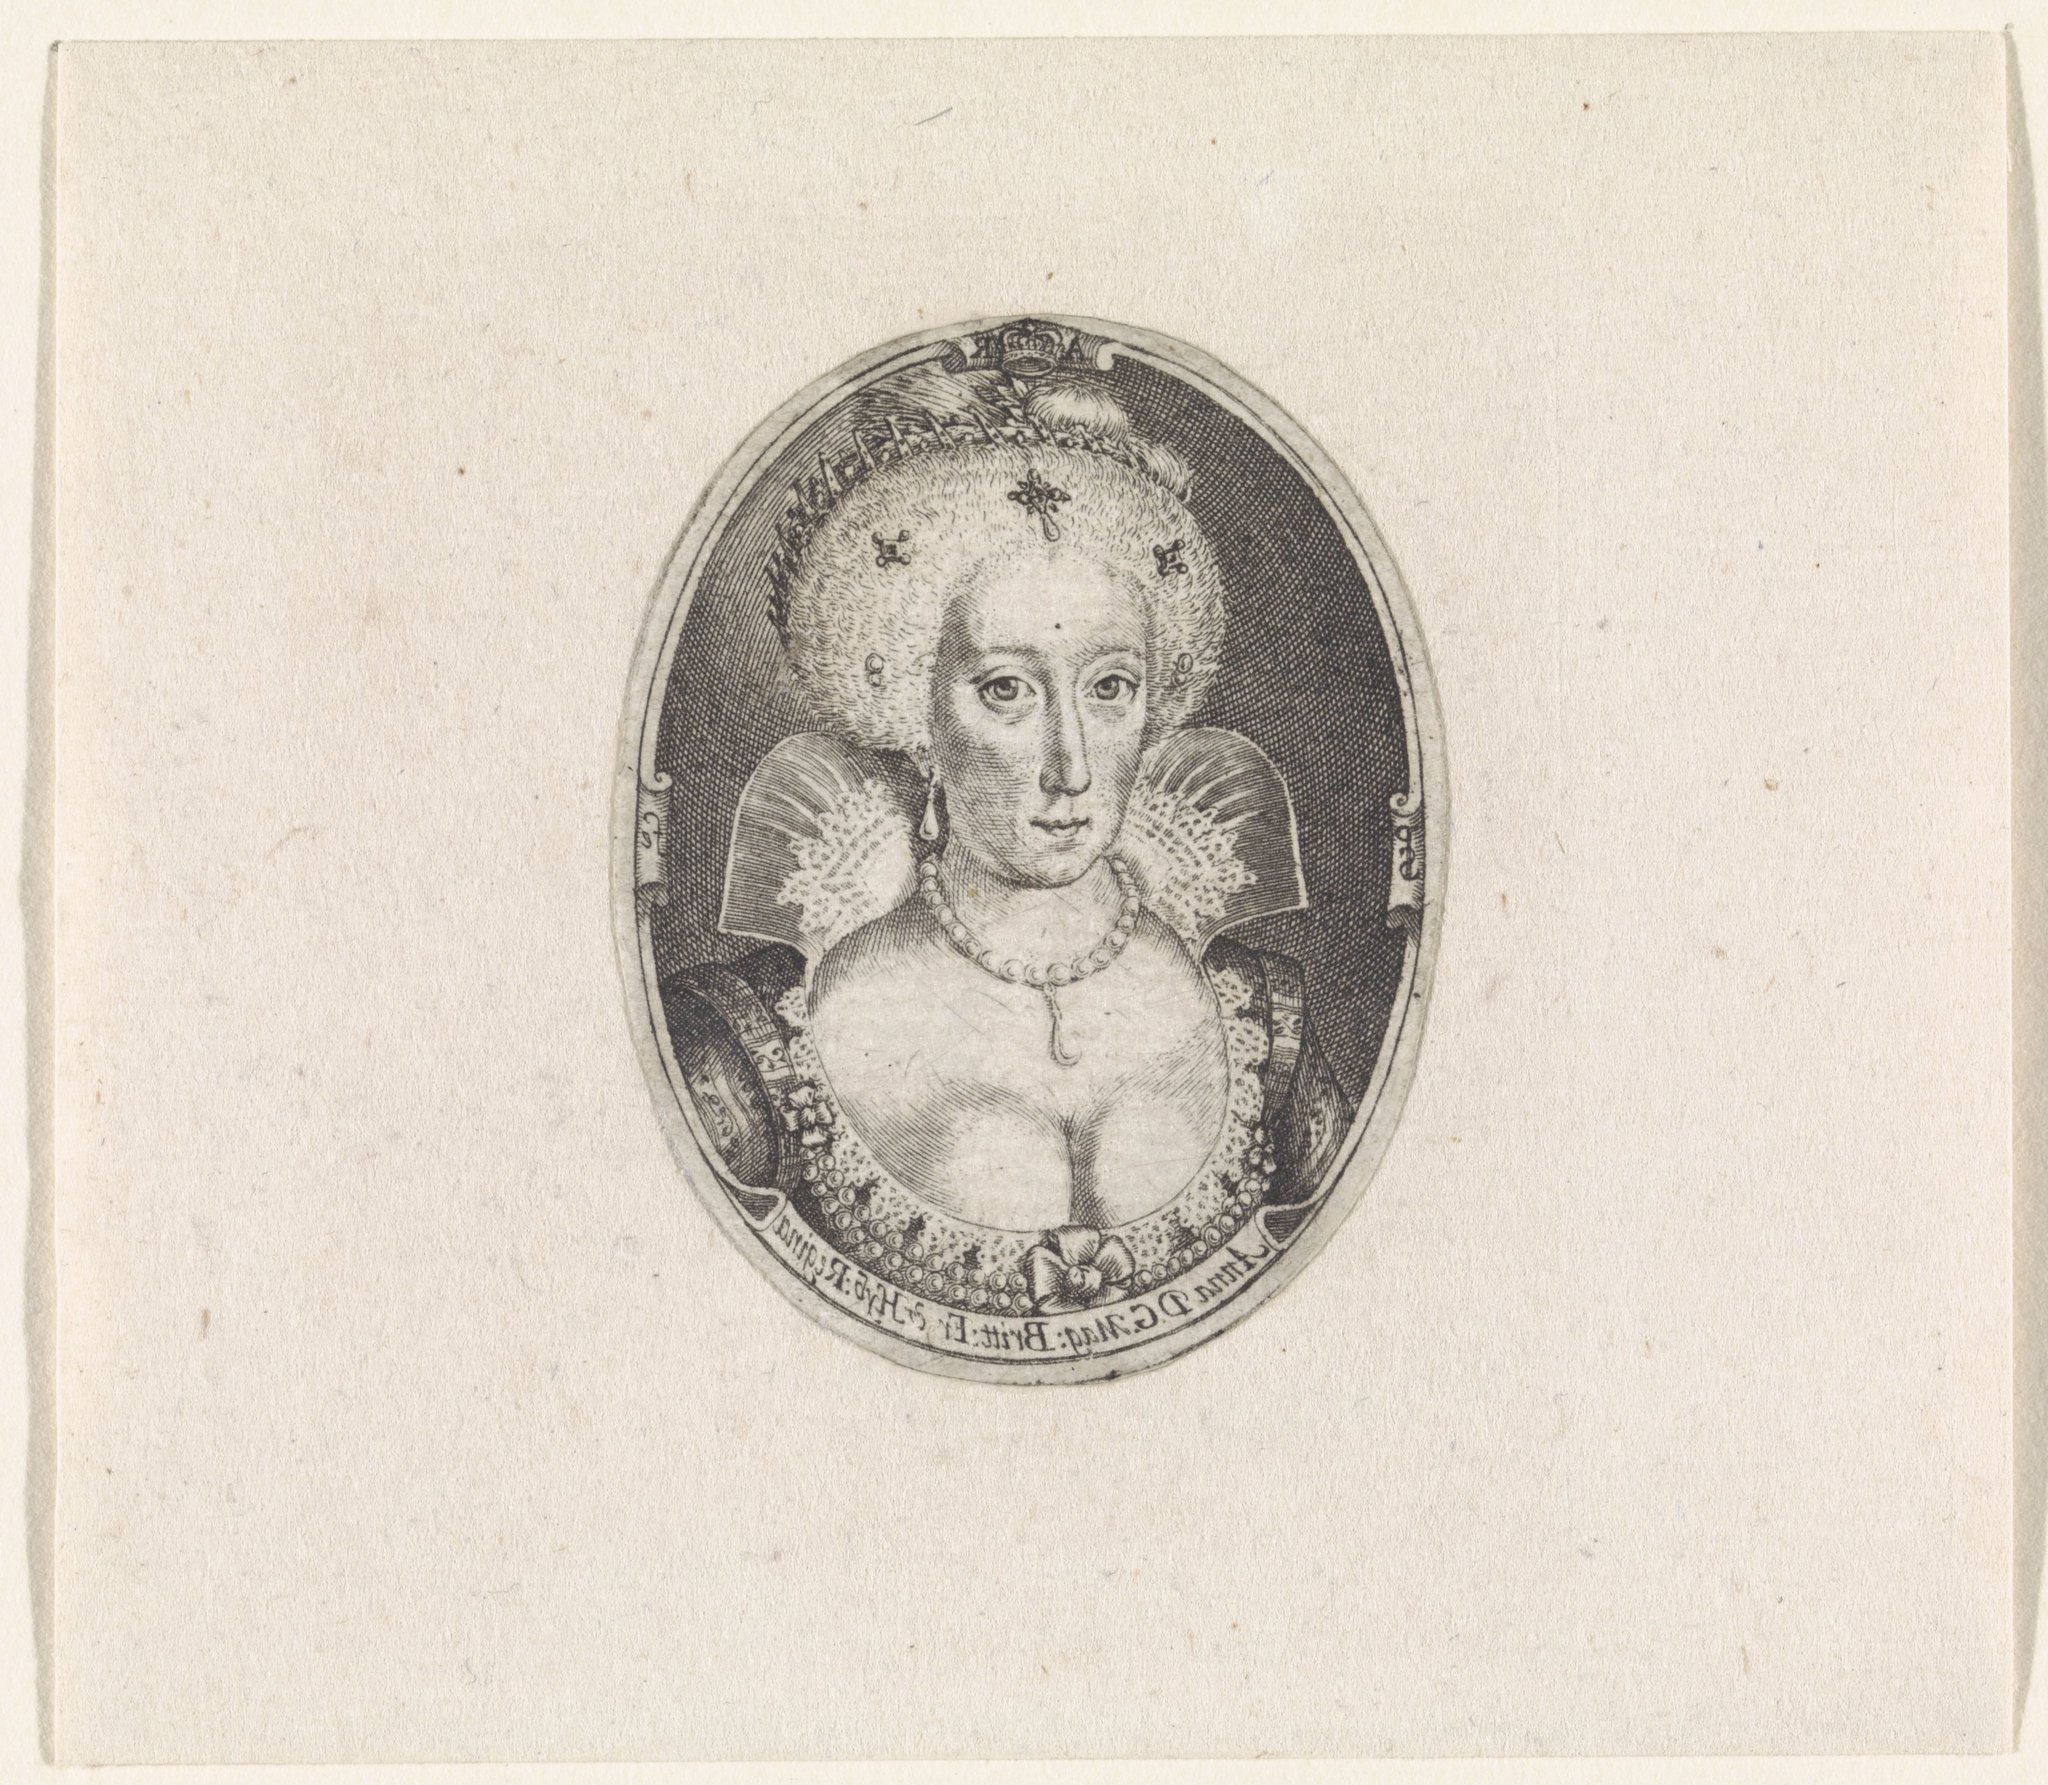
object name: print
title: Portret van Anna van Denemarken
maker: simon van de passe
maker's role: print maker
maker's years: 1595-1647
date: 1605-1647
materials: paper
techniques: engraving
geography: london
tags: anna van denemarken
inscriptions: collector's mark: Lugt 2228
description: Medaillon met het portret van Anna van Denemarken, koningin van Engeland. Onder het portret de naam en functie van de geportretteerde in het Latijn, in spiegelbeeld. Op de achterzijde van de medaille het wapenschild van de geportretteerde.